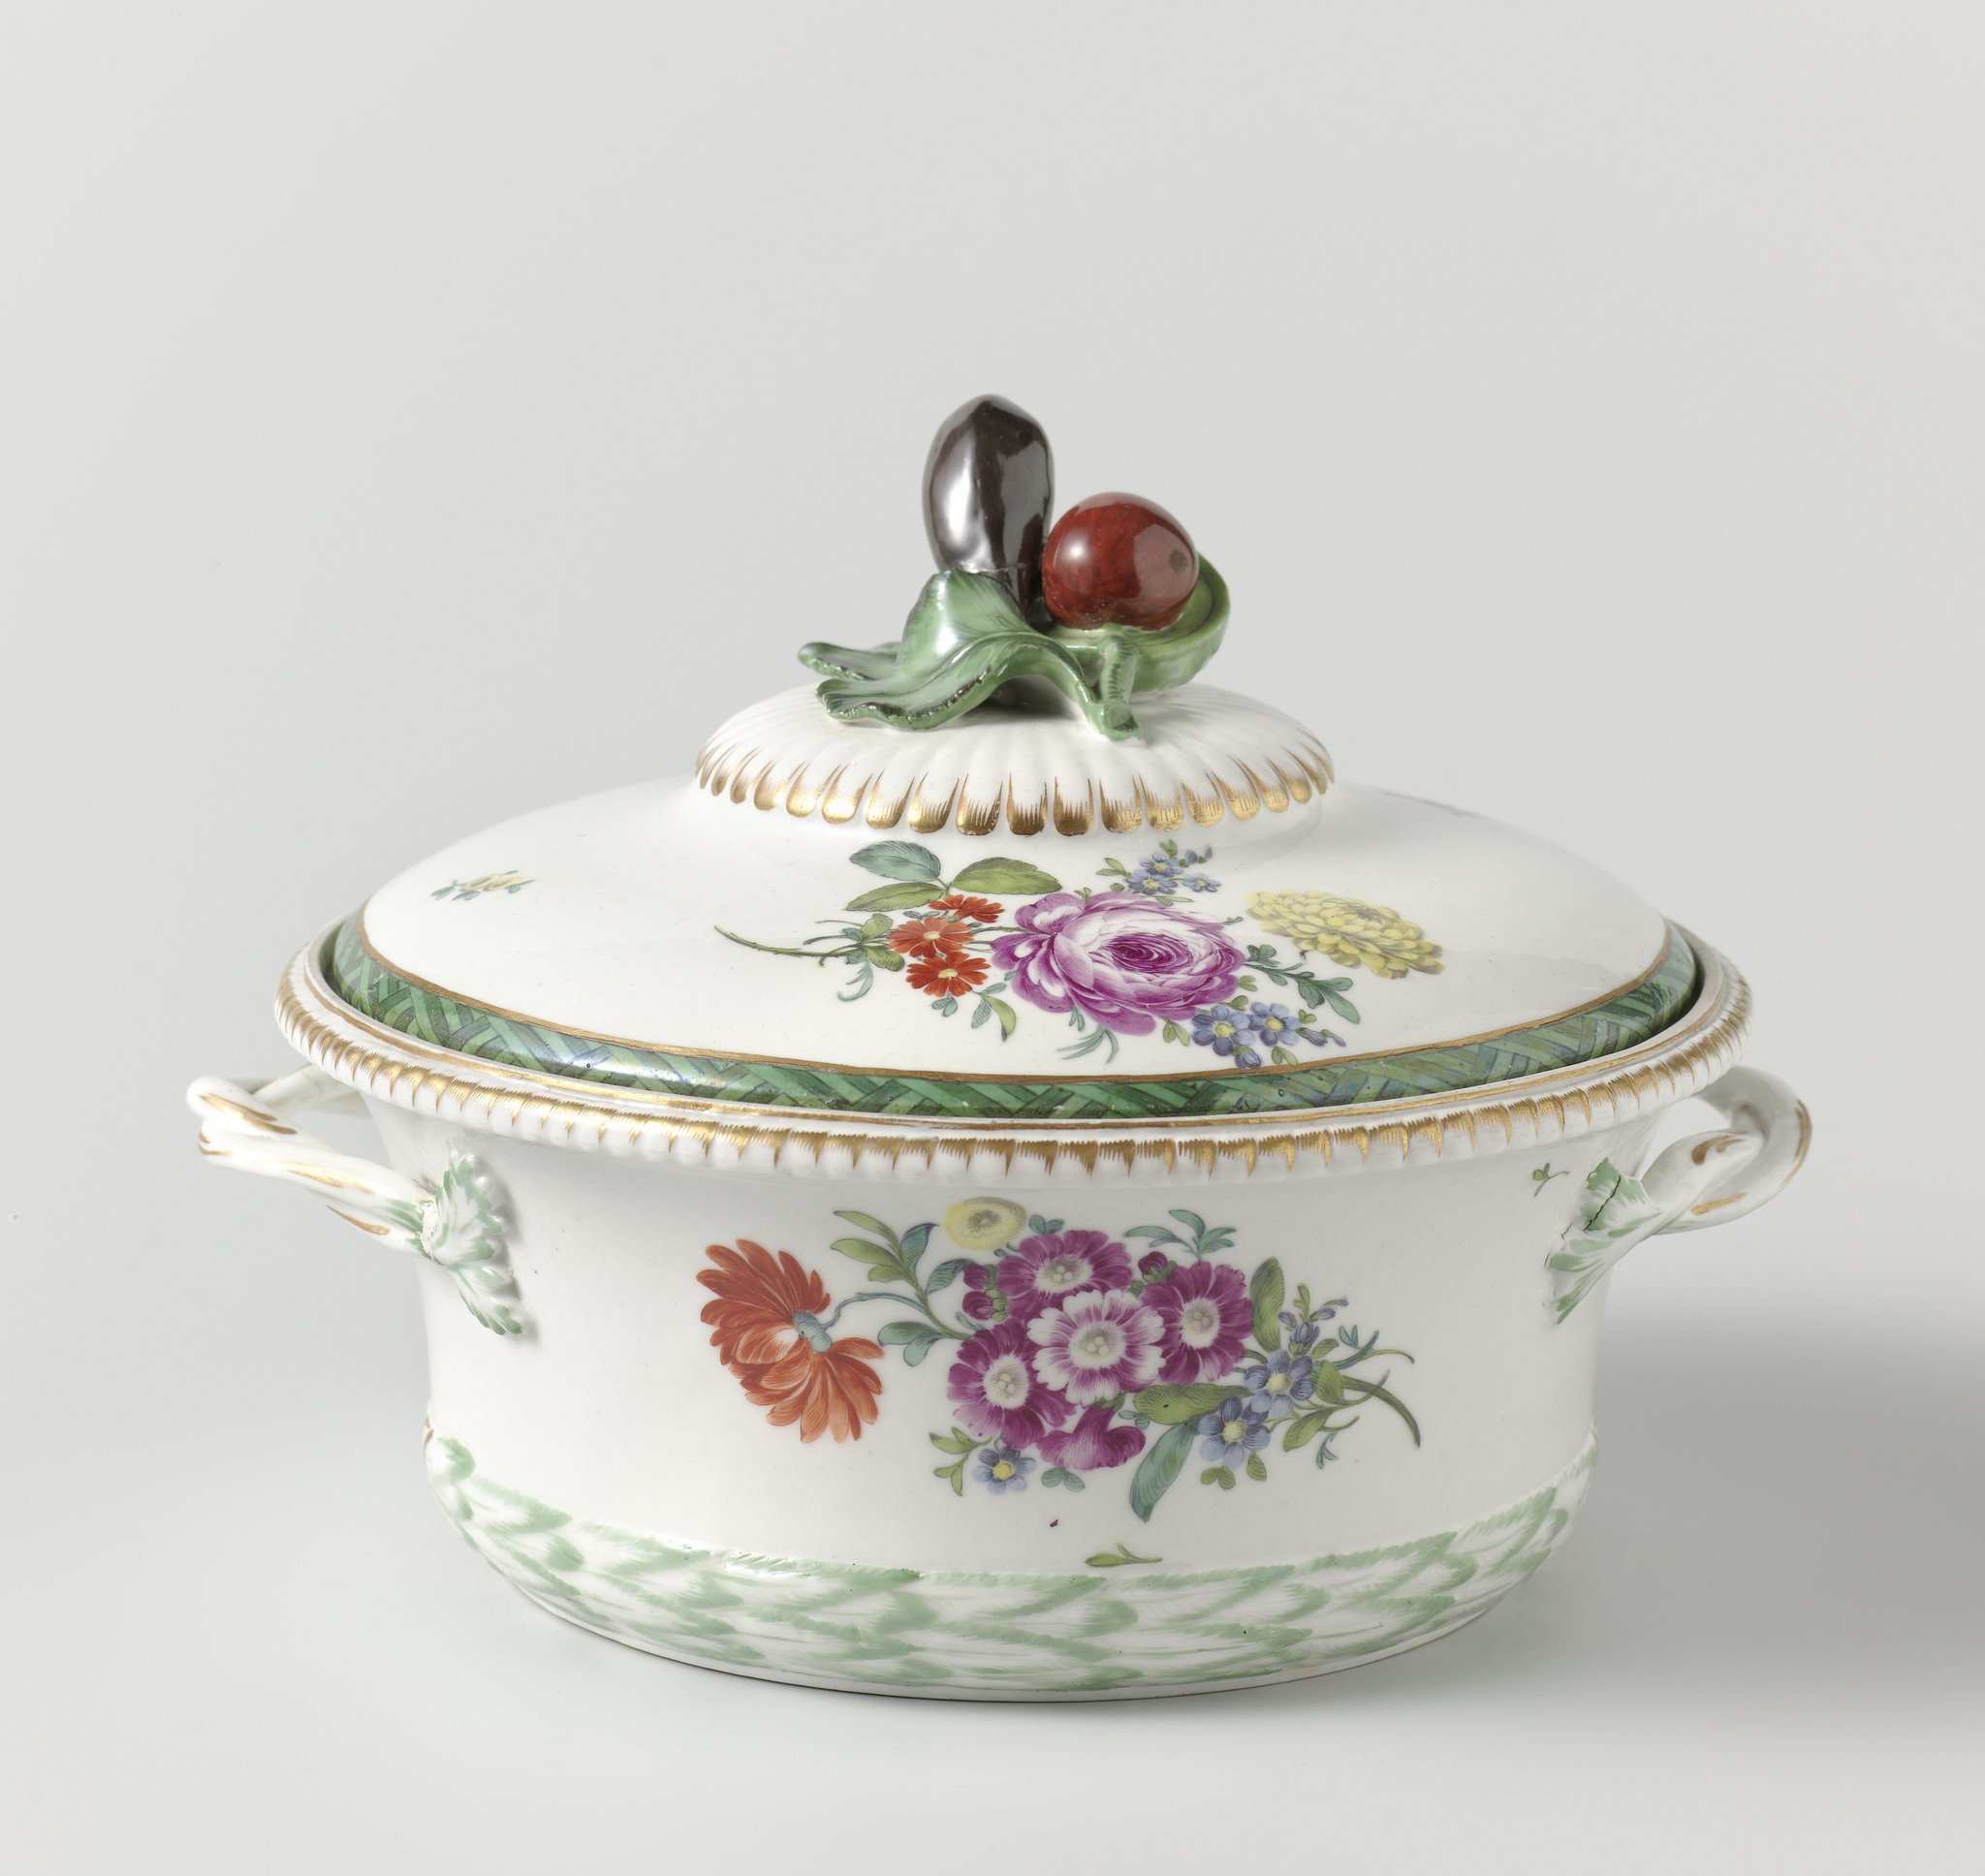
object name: tureen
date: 1778-1782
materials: porcelain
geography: loosdrecht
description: Manufactuur Oud-Loosdrecht Loosdrecht, c. 1778–1782 hard-paste porcelain